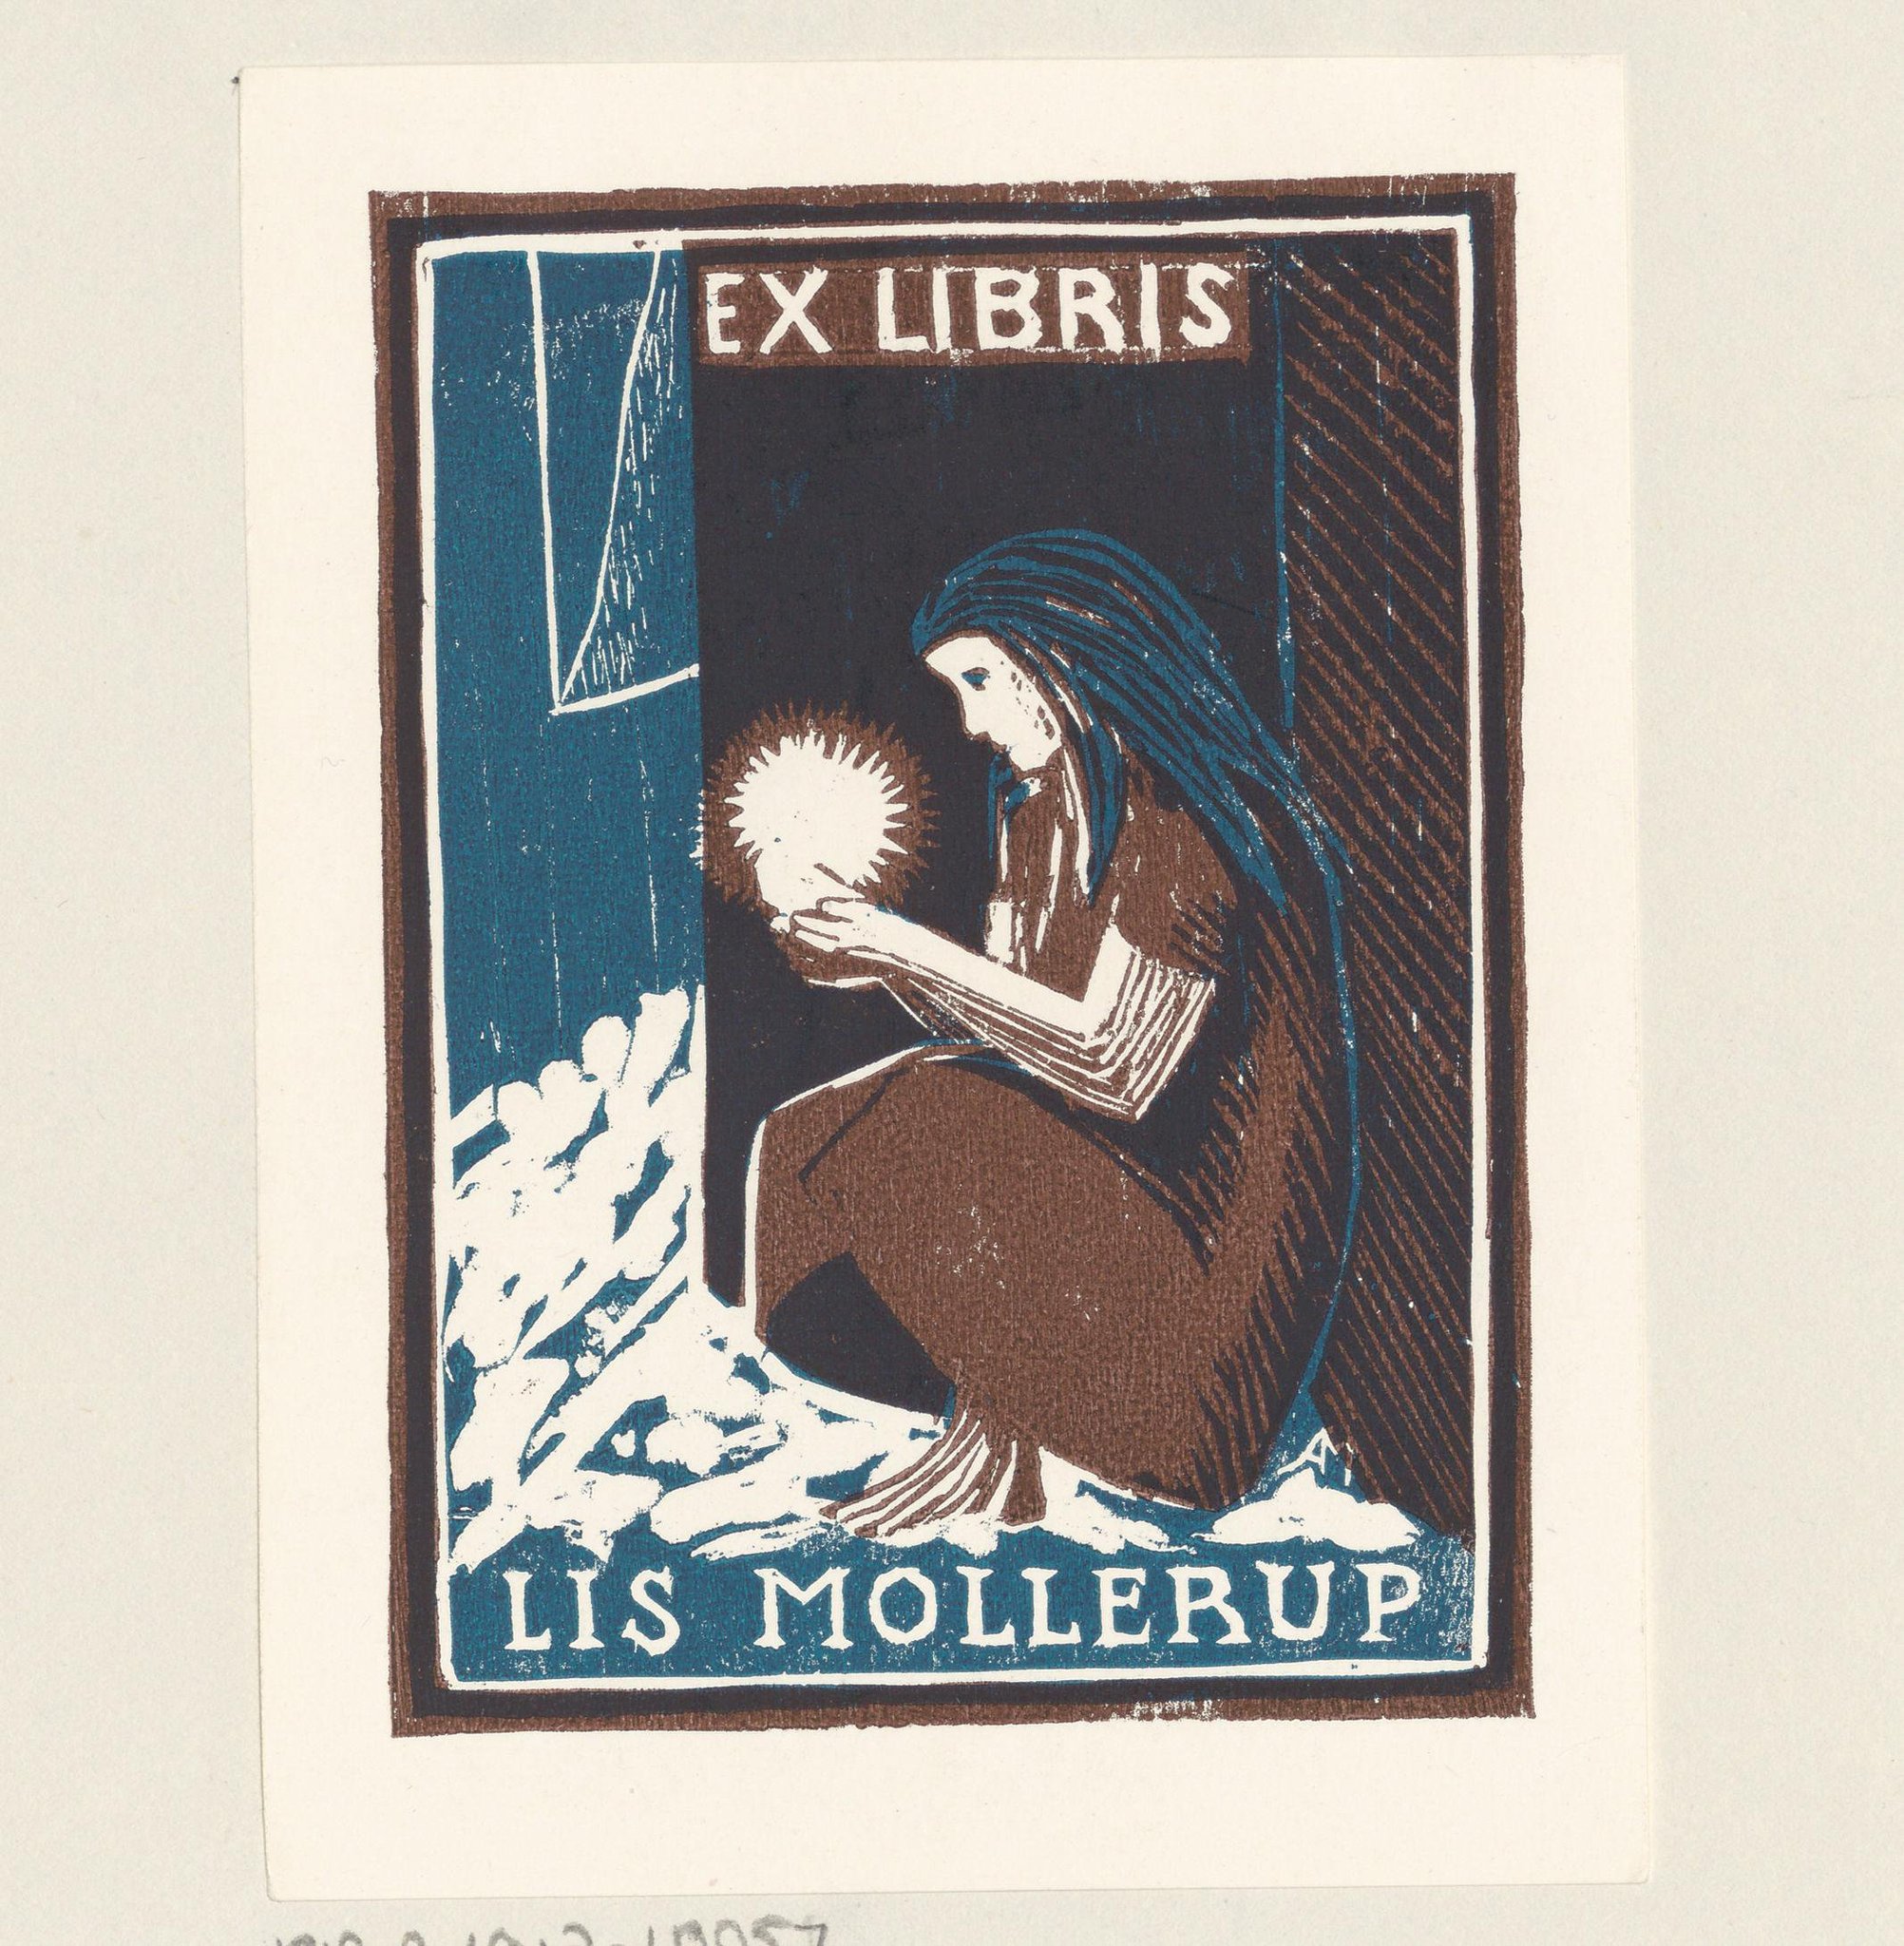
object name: bookplate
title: Ex libris van Lis Mollerup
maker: svend aage mollerup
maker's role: print maker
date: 1900-1999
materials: paper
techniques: woodcut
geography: denmark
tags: match, squatting, crouching figure - aa - female human figure